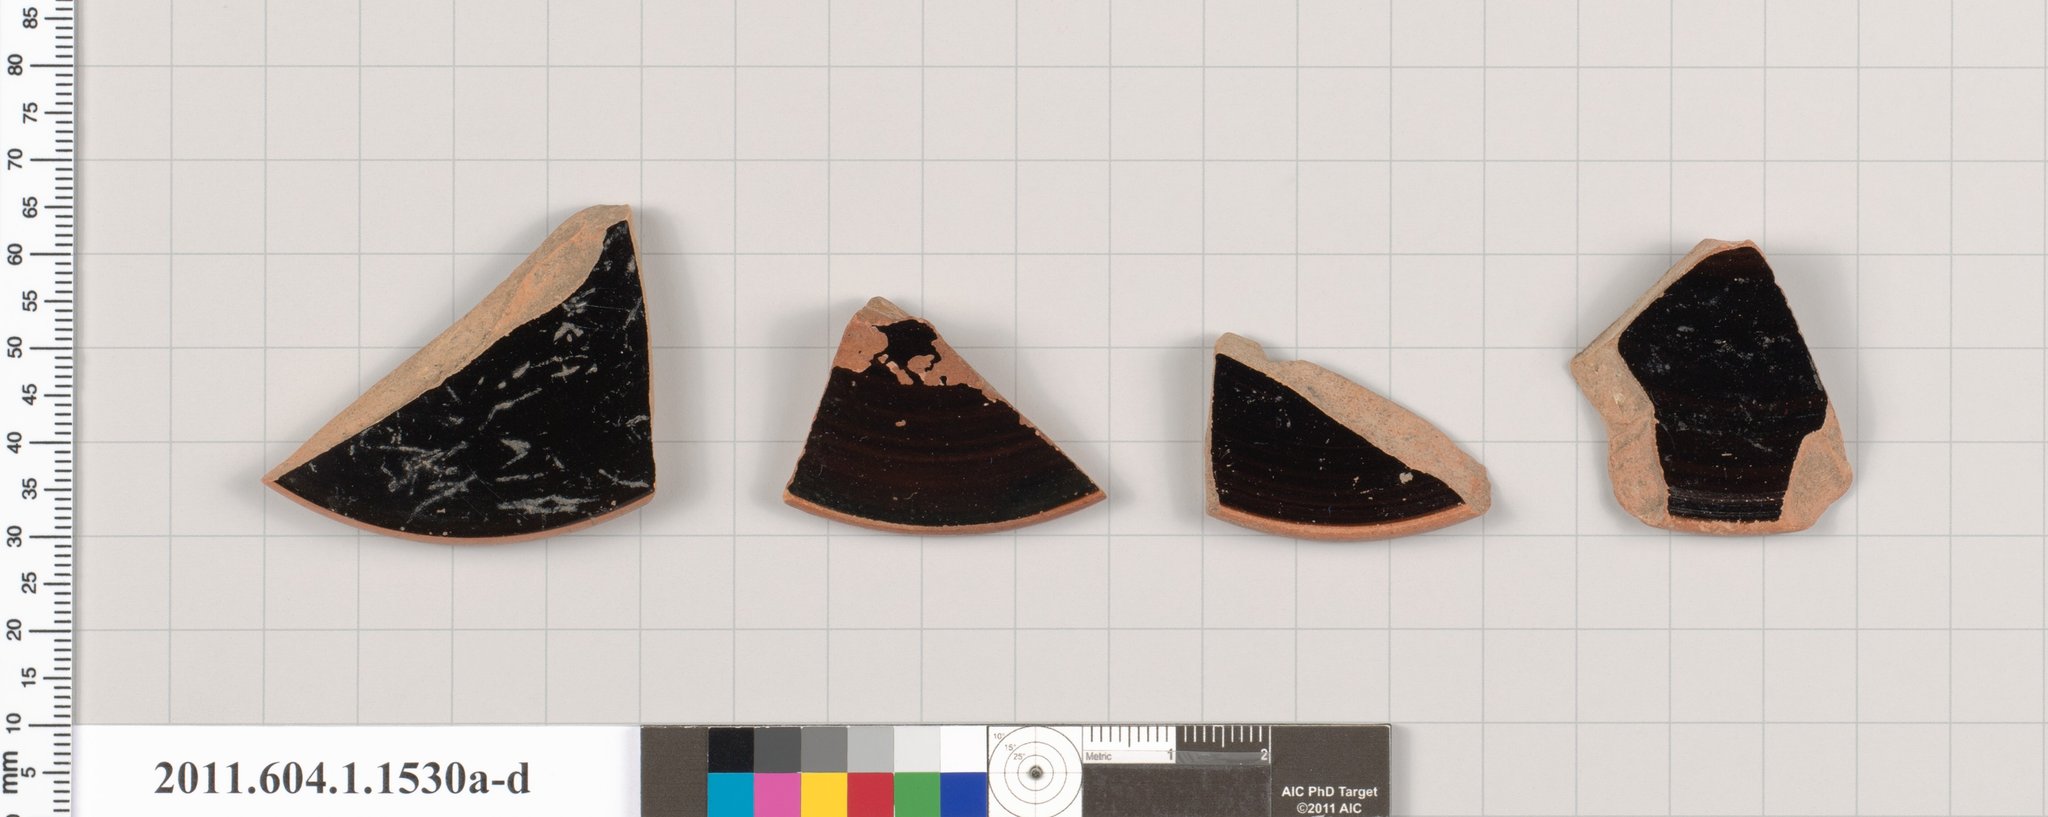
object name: kylix fragment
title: Terracotta fragments of kylikes (drinking cups)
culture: greek, attic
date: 500-401 BCE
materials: terracotta